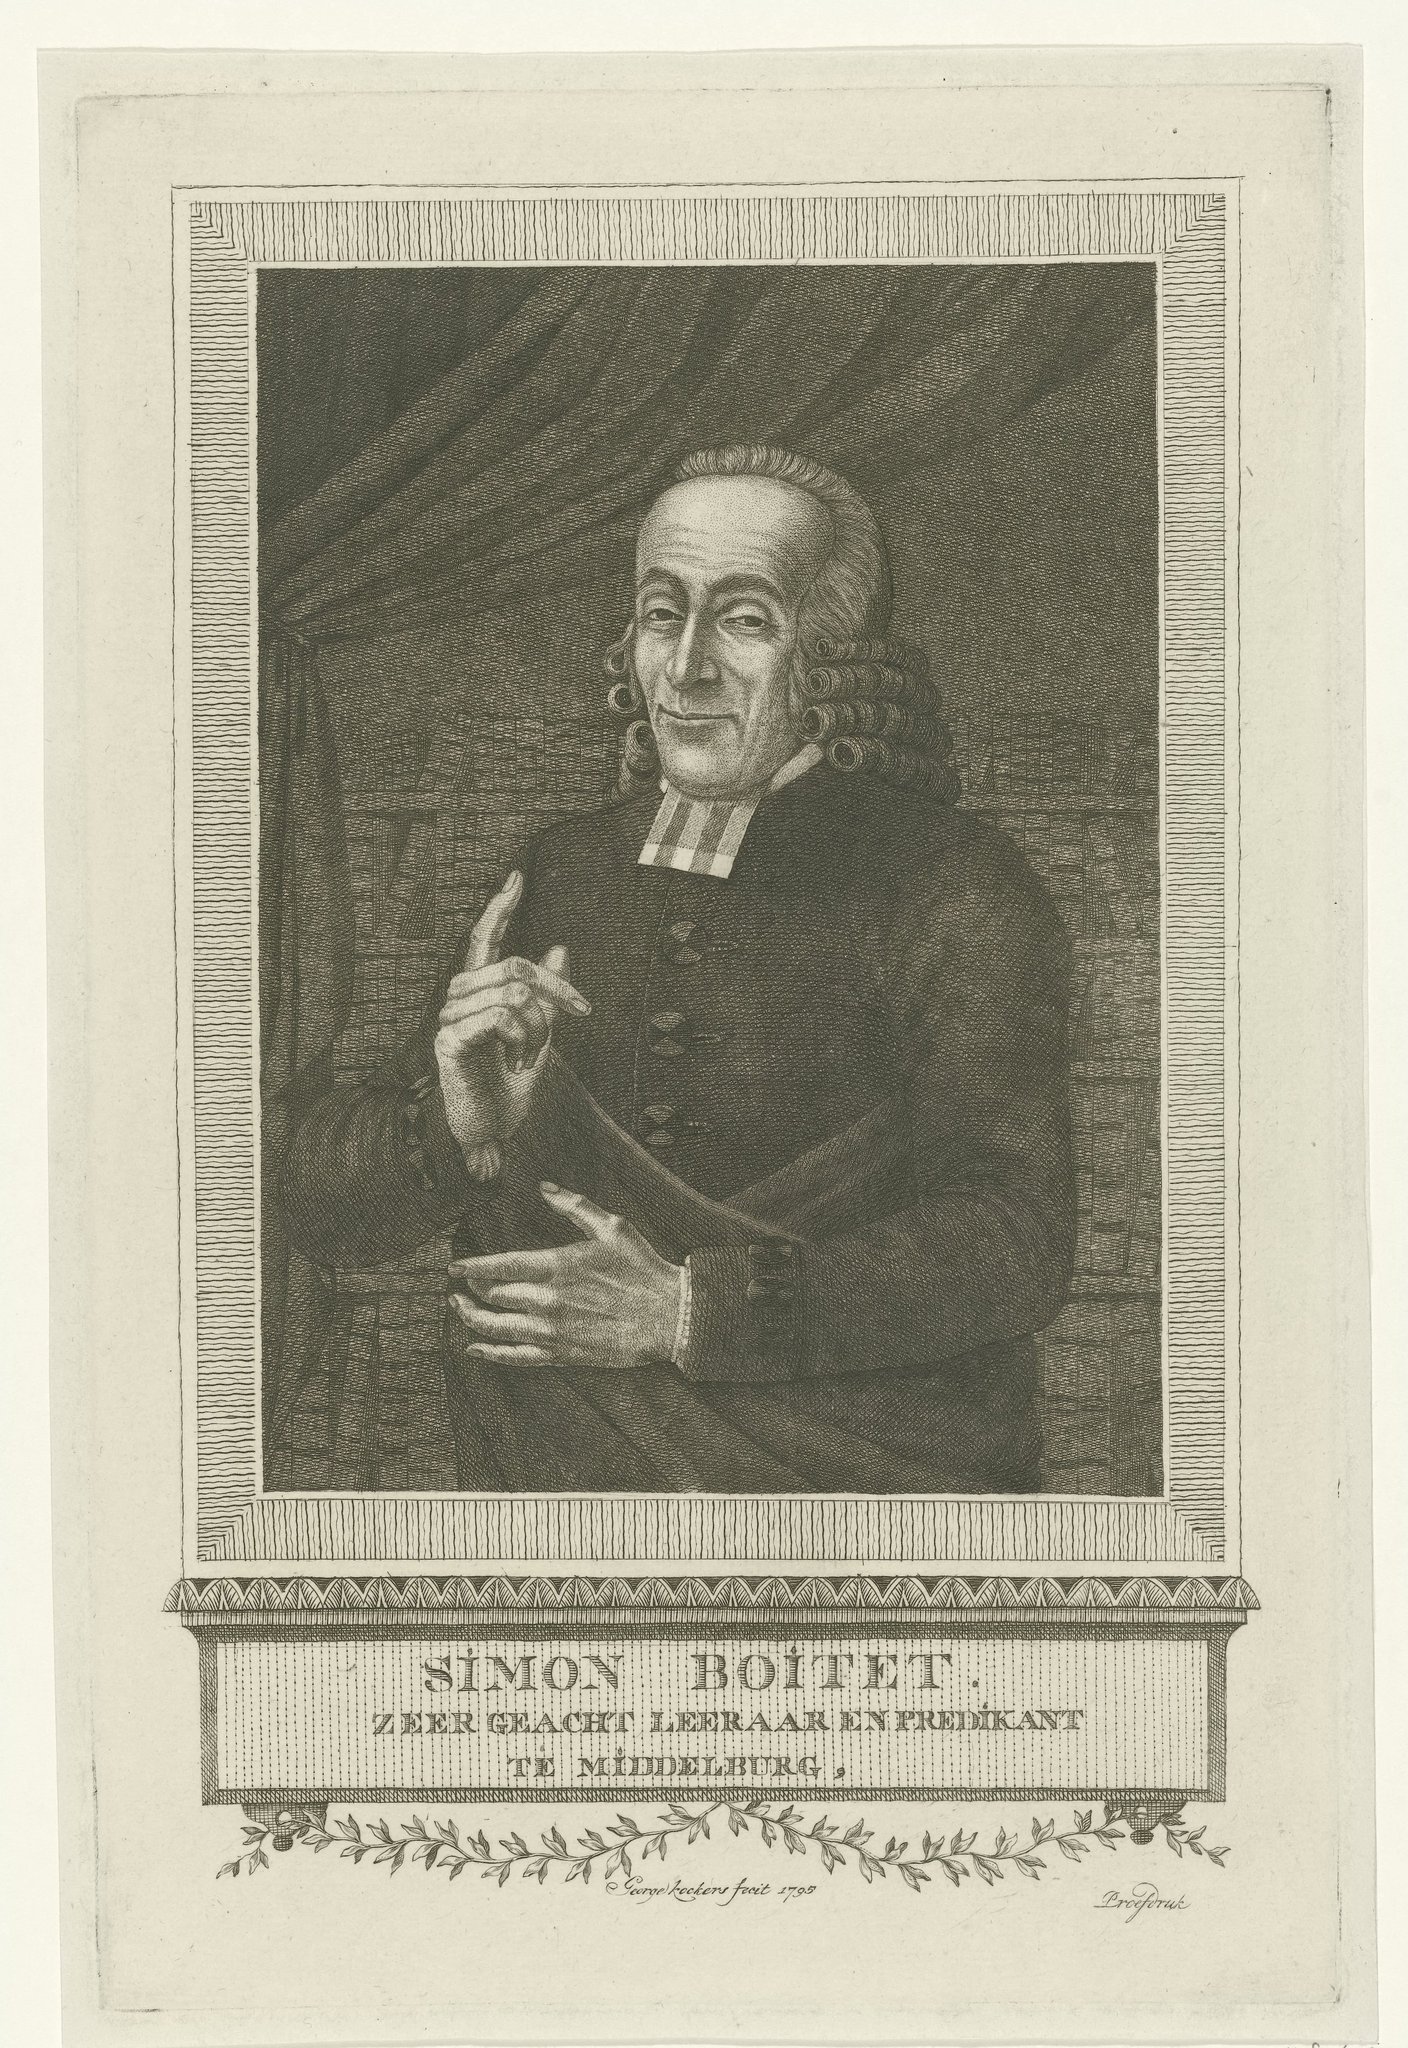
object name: print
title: Portret van Simon Boitet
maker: george kockers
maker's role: goldsmith, print maker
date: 1795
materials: paper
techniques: engraving, etching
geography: middelburg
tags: wig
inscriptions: collector's mark: Lugt 2228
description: Portret ten halven lijve naar links van Simon Boitet, docent en predikant te Middelburg. Boitet, staande voor een boekenkast, draagt een batterijpruik en een bef. Onder het portret een drieregelig onderschrift met zijn naam en titels.